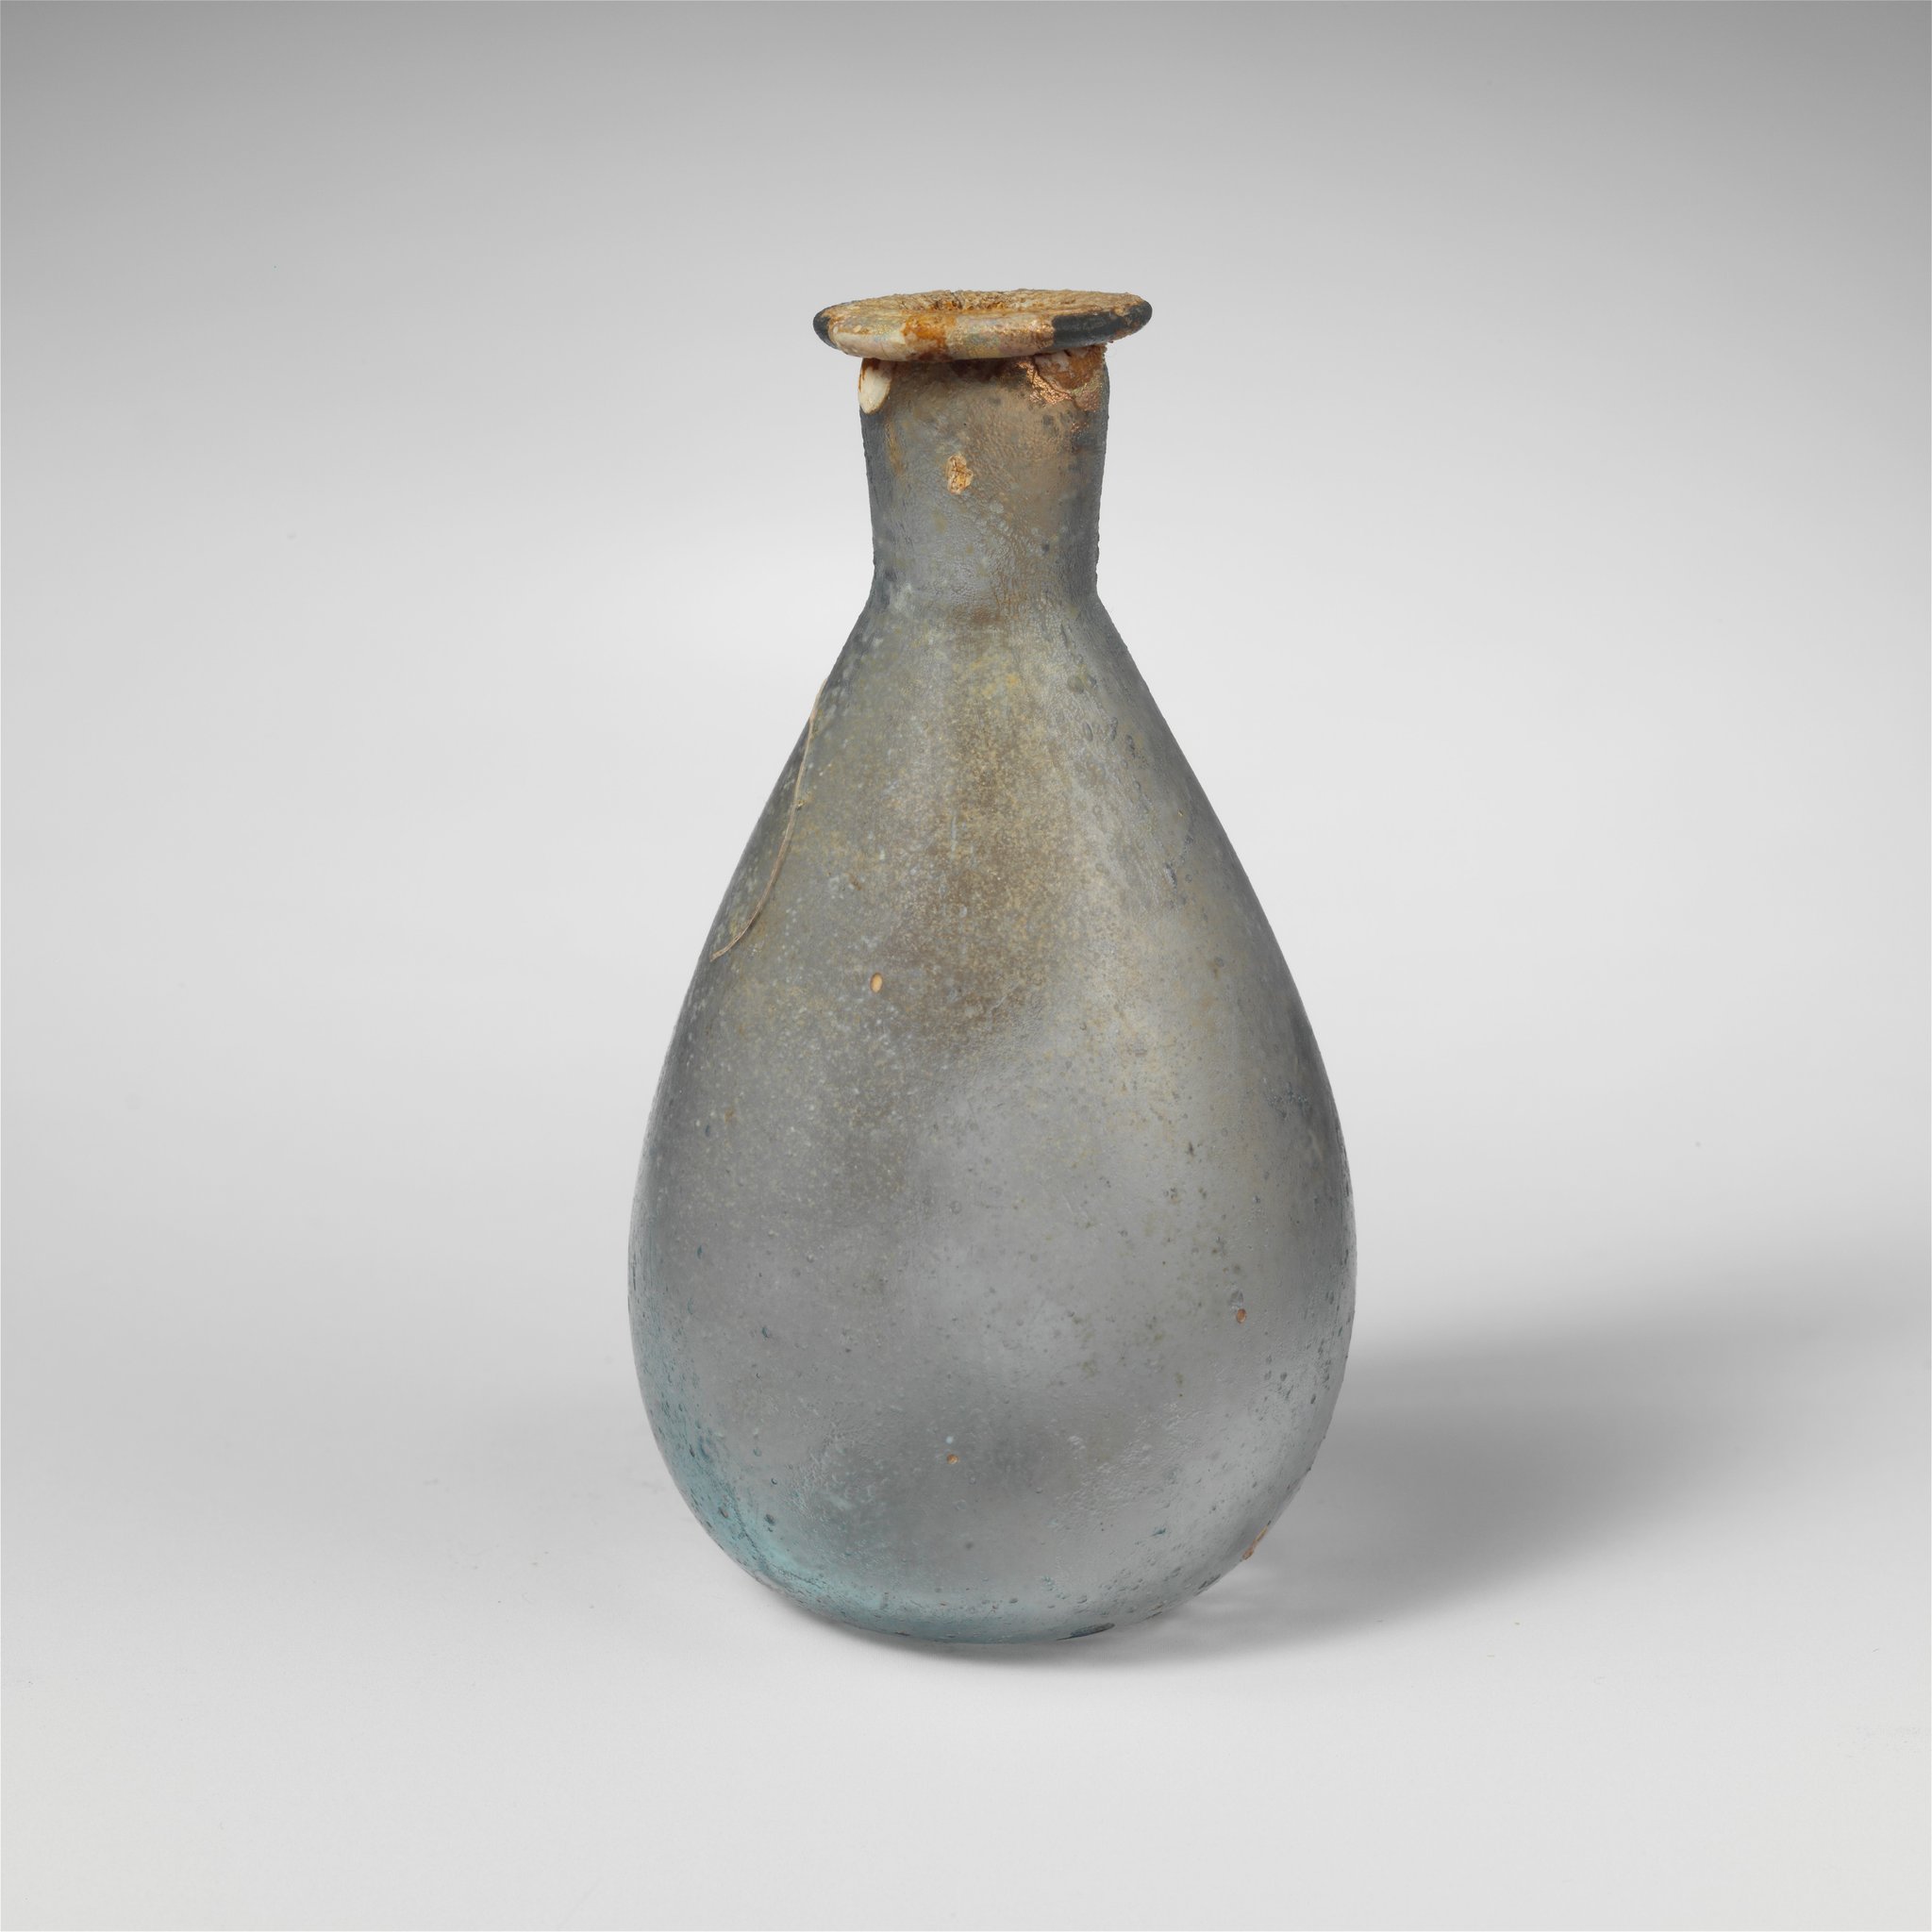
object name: perfume bottle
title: Glass perfume bottle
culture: roman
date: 1-100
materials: glass